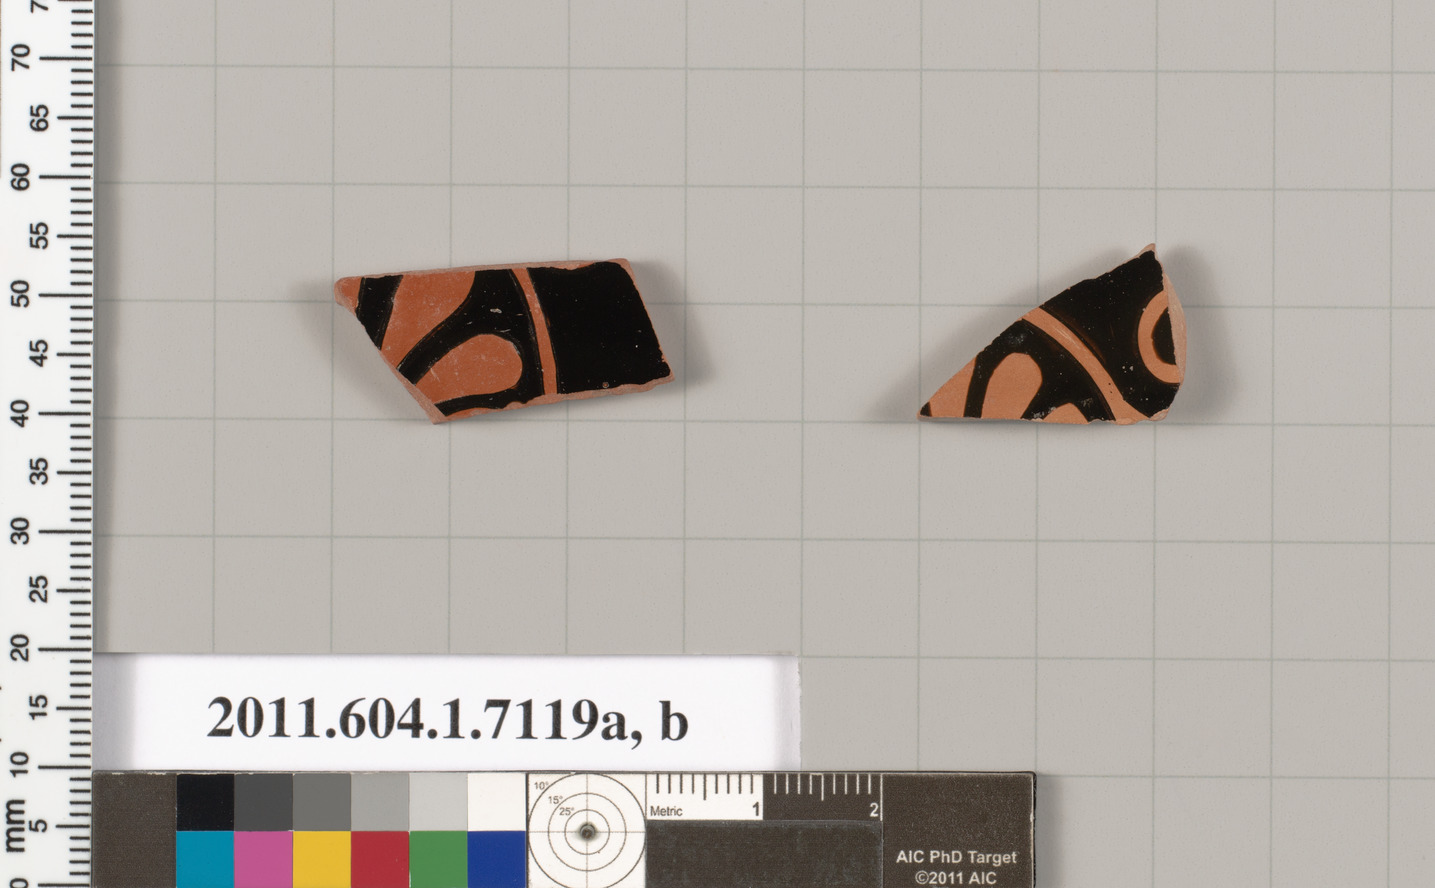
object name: kylix fragment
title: Terracotta fragments of kylikes (drinking cups)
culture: greek, attic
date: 500-480 BCE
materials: terracotta